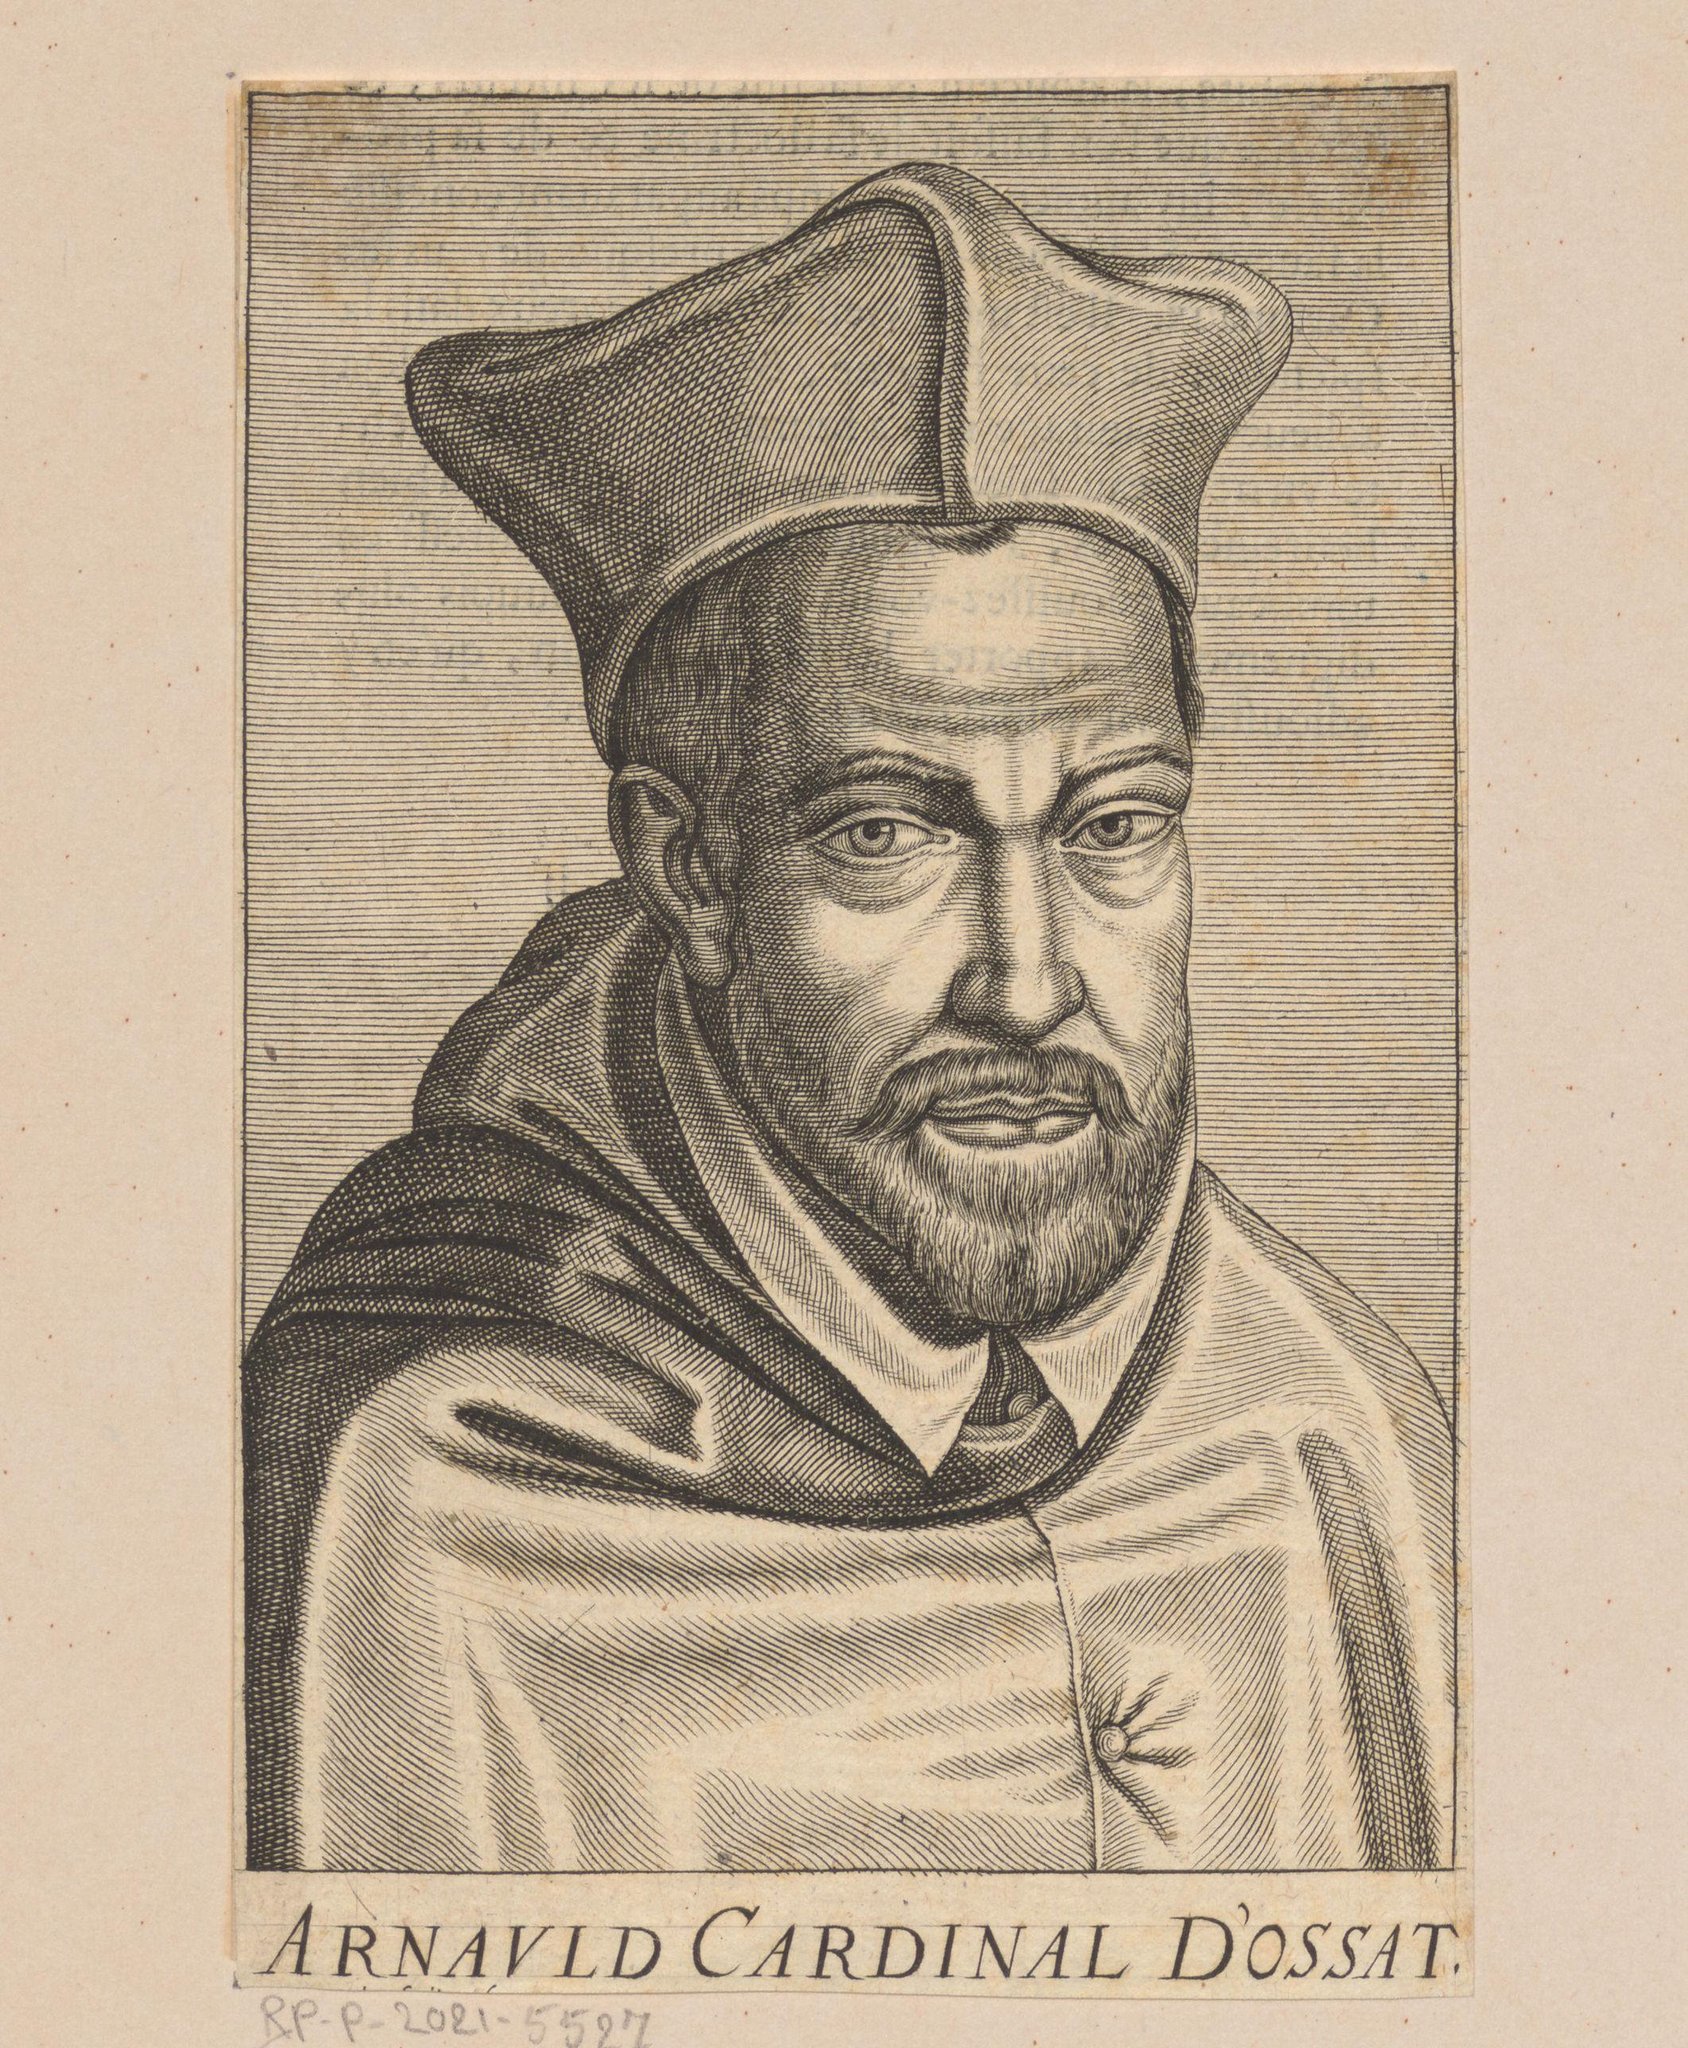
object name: book illustration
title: Portret van Arnaud d'Ossat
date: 1627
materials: paper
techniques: engraving, letterpress printing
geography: paris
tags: rome, historical persons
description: Prent uit: Ossat, Arnaud d'. Lettres de l'illustrissime et reverendissime cardinal d'Ossat. Parijs: Joseph Bouillerot, 1627.